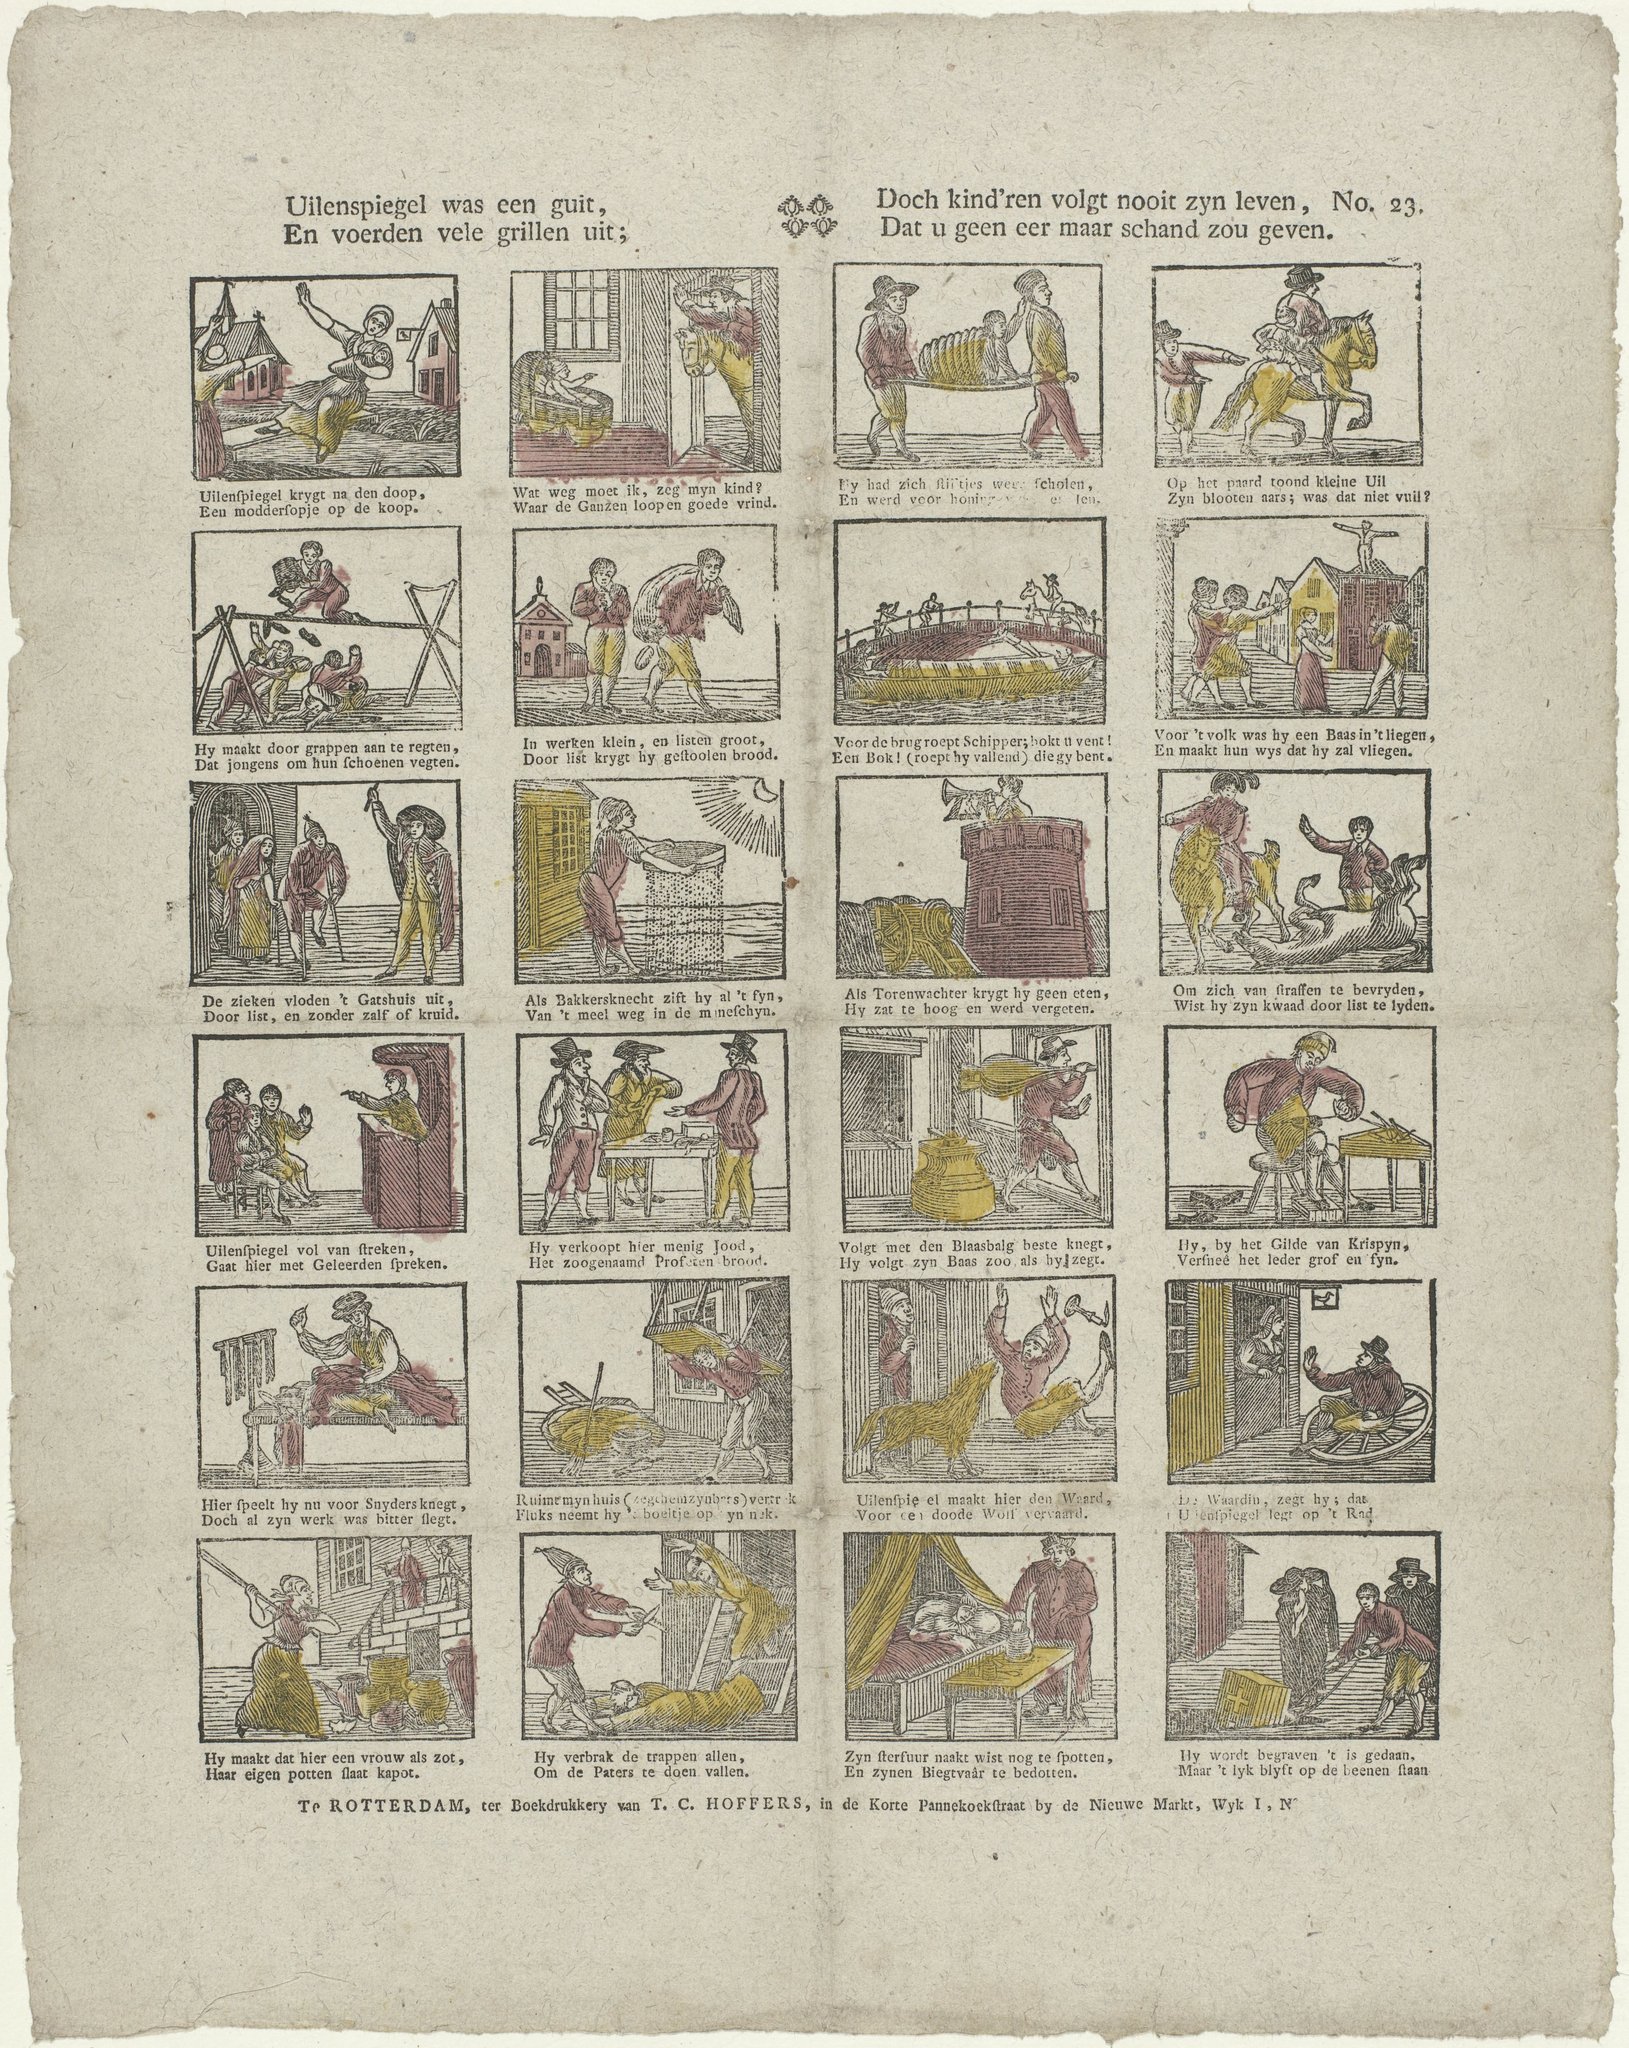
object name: popular print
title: Uilenspiegel was een guit, / En voerden vele grillen uit; / Doch kind'ren volgt nooit zyn leven, / Dat u geen eer maar schand zou geven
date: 1820-1838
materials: paper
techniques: colour, letterpress printing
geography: rotterdam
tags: eulenspiegel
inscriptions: collector's mark: Lugt 2760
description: Blad met 24 voorstellingen over het leven van Tijl Uilenspiegel. Onder elke afbeelding een tweeregelig vers. Genummerd rechtsboven: No. 23.